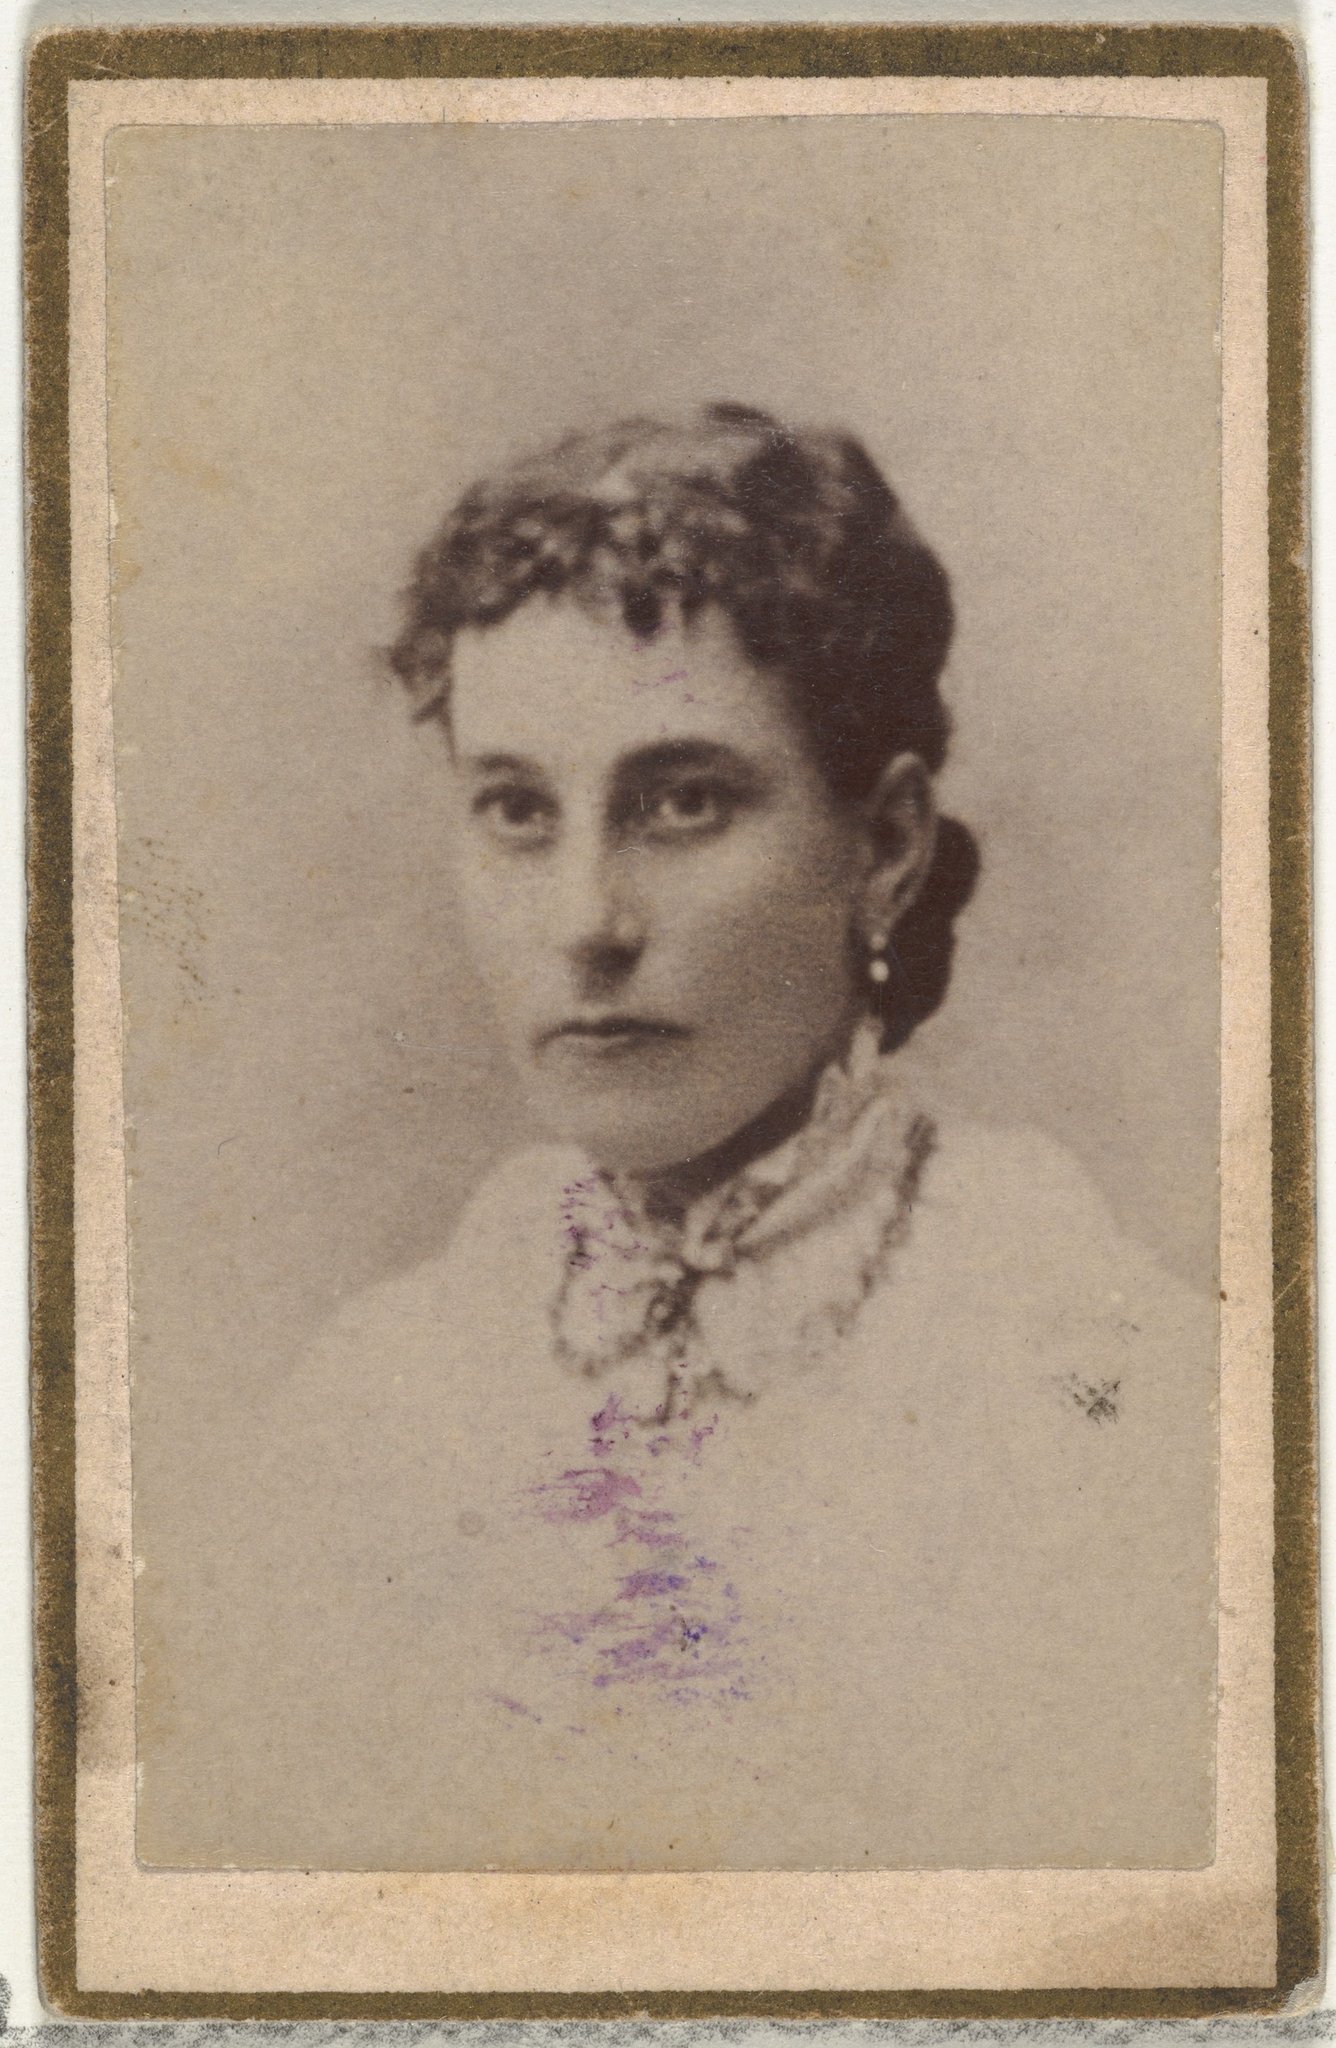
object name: photograph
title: From the Actresses and Celebrities series (N60, Type 2) promoting Little Beauties Cigarettes for Allen & Ginter brand tobacco products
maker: allen & ginter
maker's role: publisher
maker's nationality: american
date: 1887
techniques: albumen silver print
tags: portraits,women,actresses